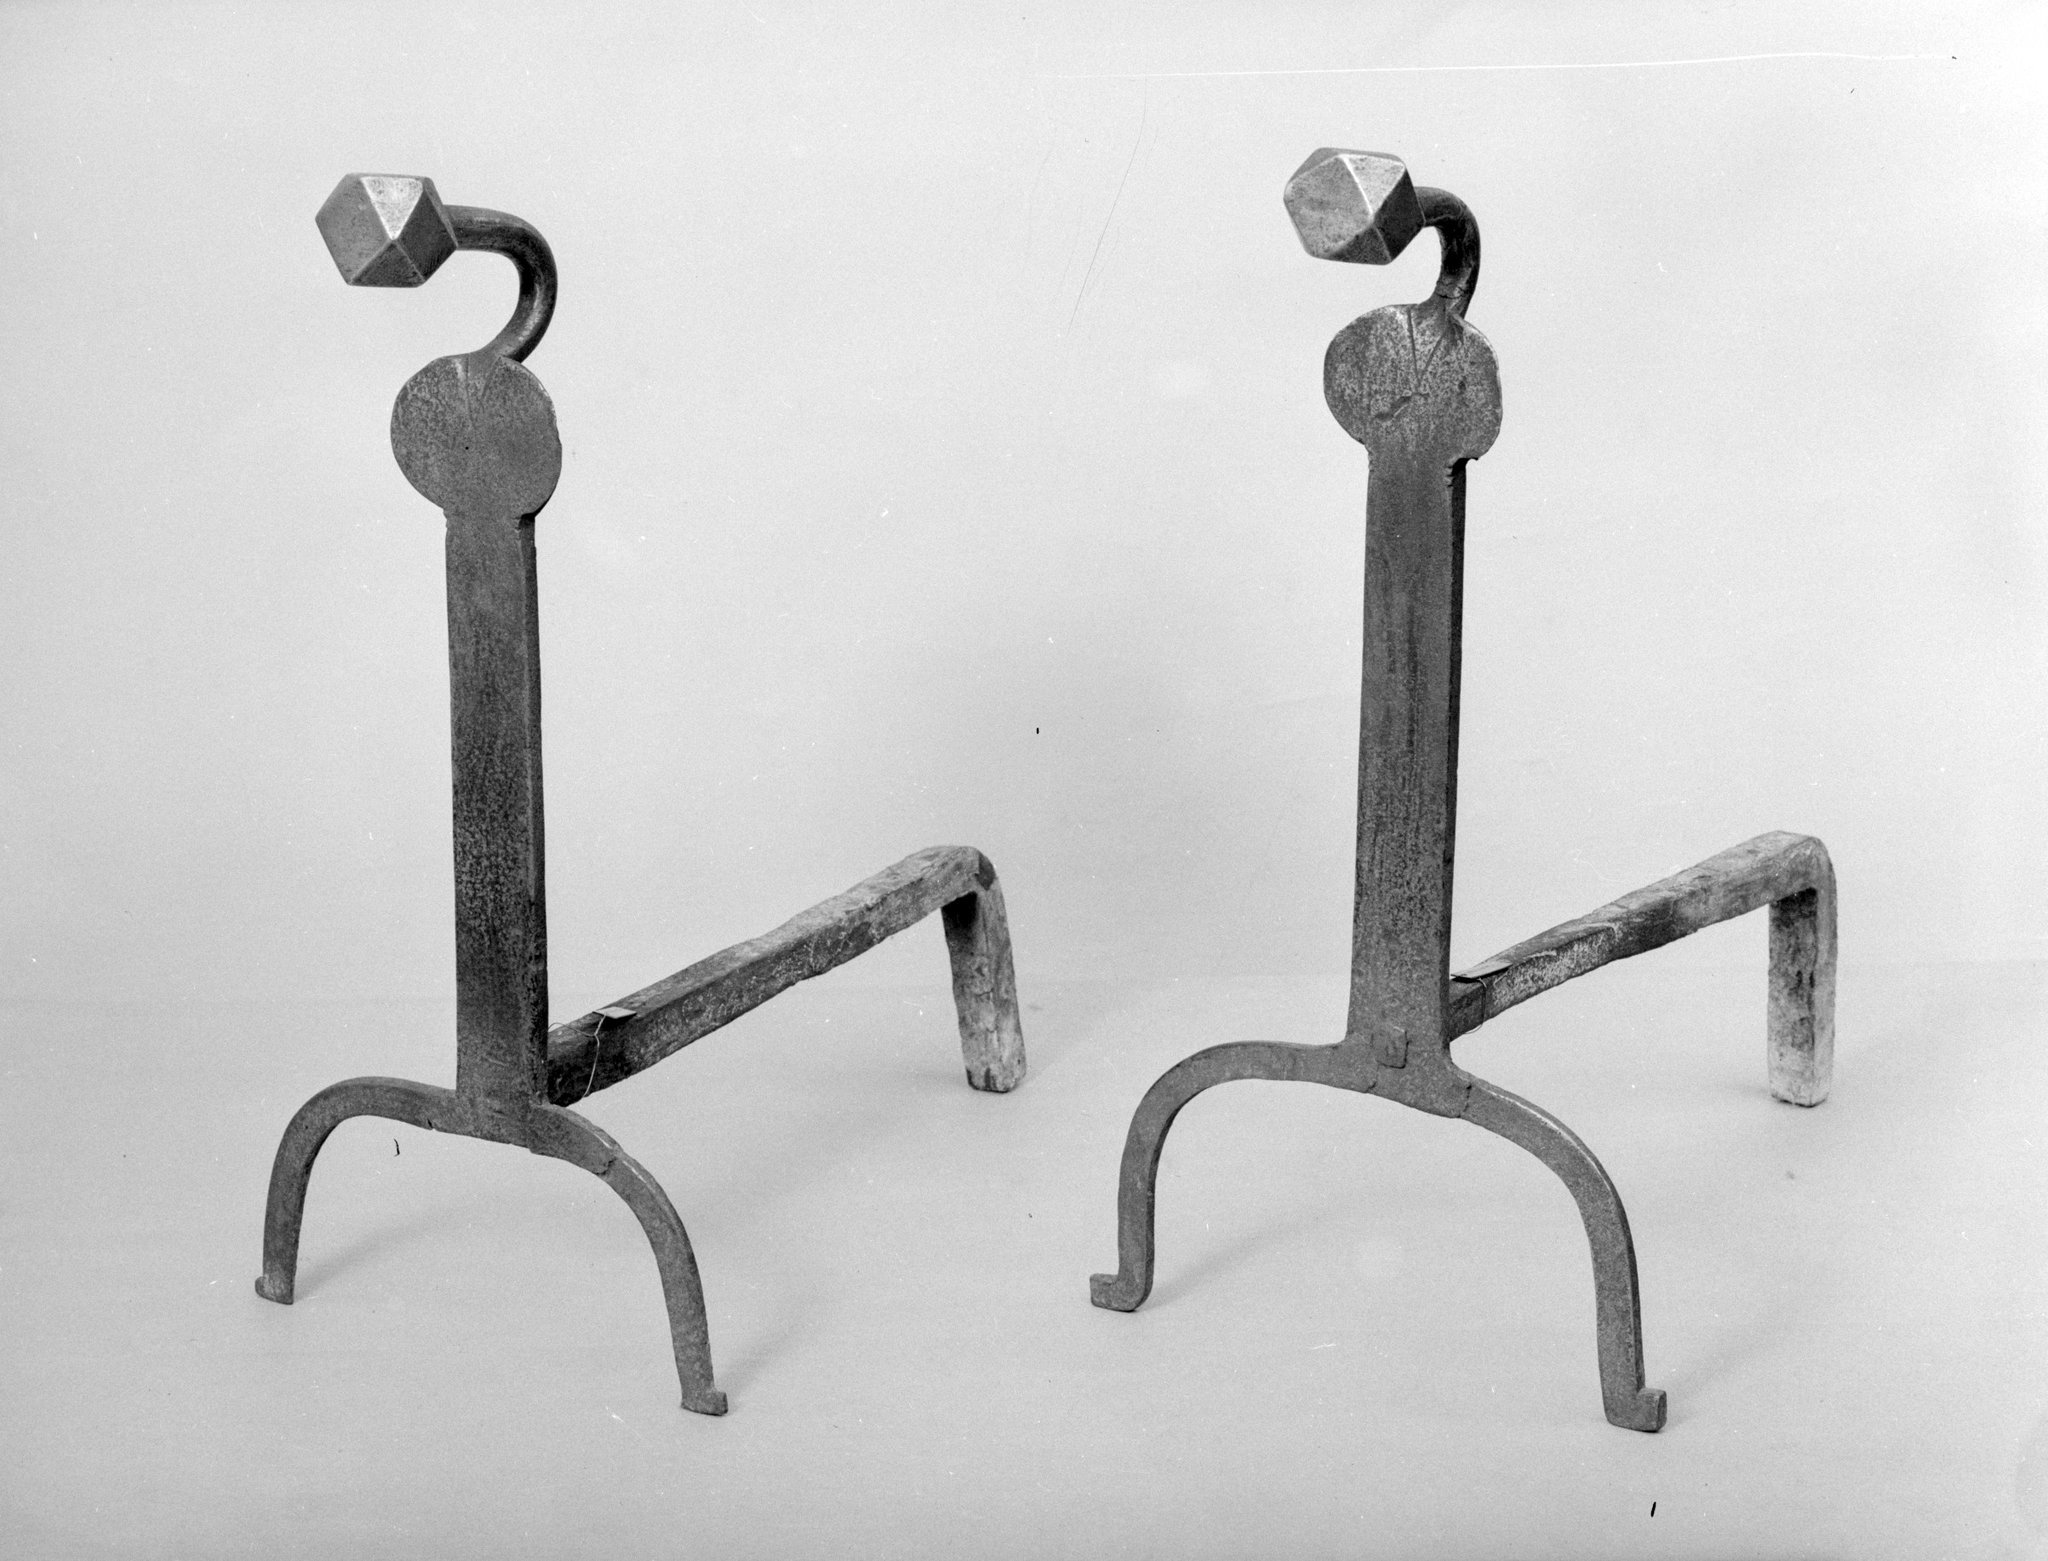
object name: andiron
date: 1700-1800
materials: iron